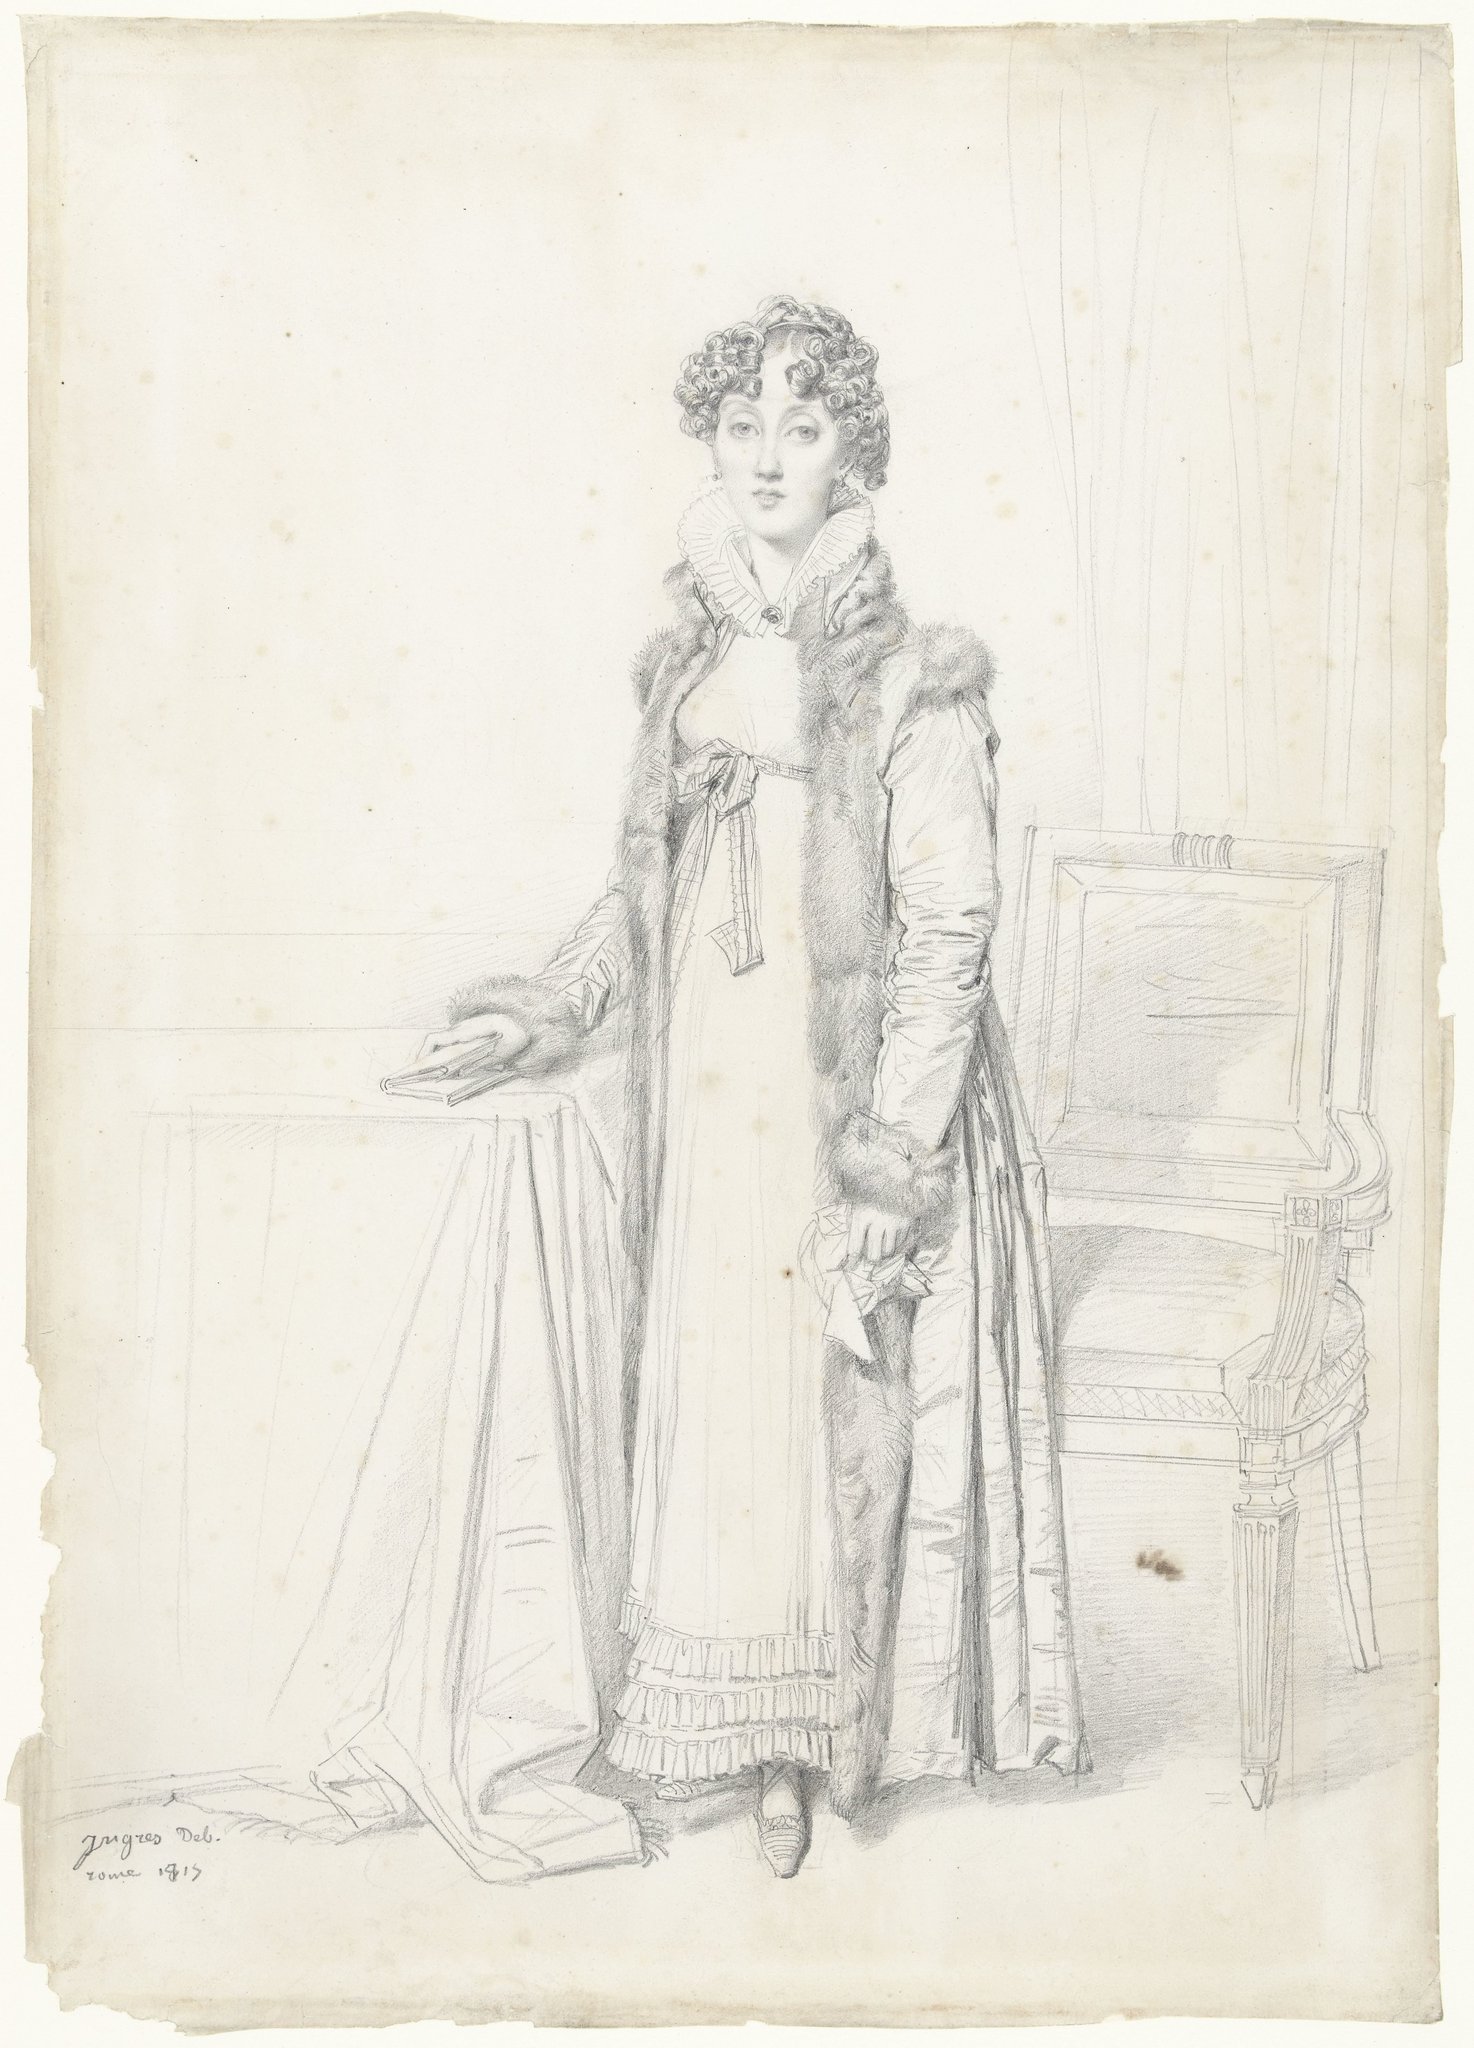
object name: drawing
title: Portret van Lady William Henry Cavendish Bentinck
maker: jean auguste dominique ingres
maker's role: draughtsman, print maker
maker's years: 1780-1867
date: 1815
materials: paper, pencil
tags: historical persons - bb - woman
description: Lord William Bentinck trouwde in 1803 met Mary Acheson, dochter van de Eral of Gosford. Na de val van napoleon verbleef het echtpaar enige tijd in Rome. Daar maakte Ingres twee tekeningen van haar alleen en één samen met haar man. Opdrachten voor portrettekeningen van Engelsen waren voor Ingres in Rome een noodzakelijke bron van inkomsten. Deze worden thans tot zijn meesterwerken gerekend.